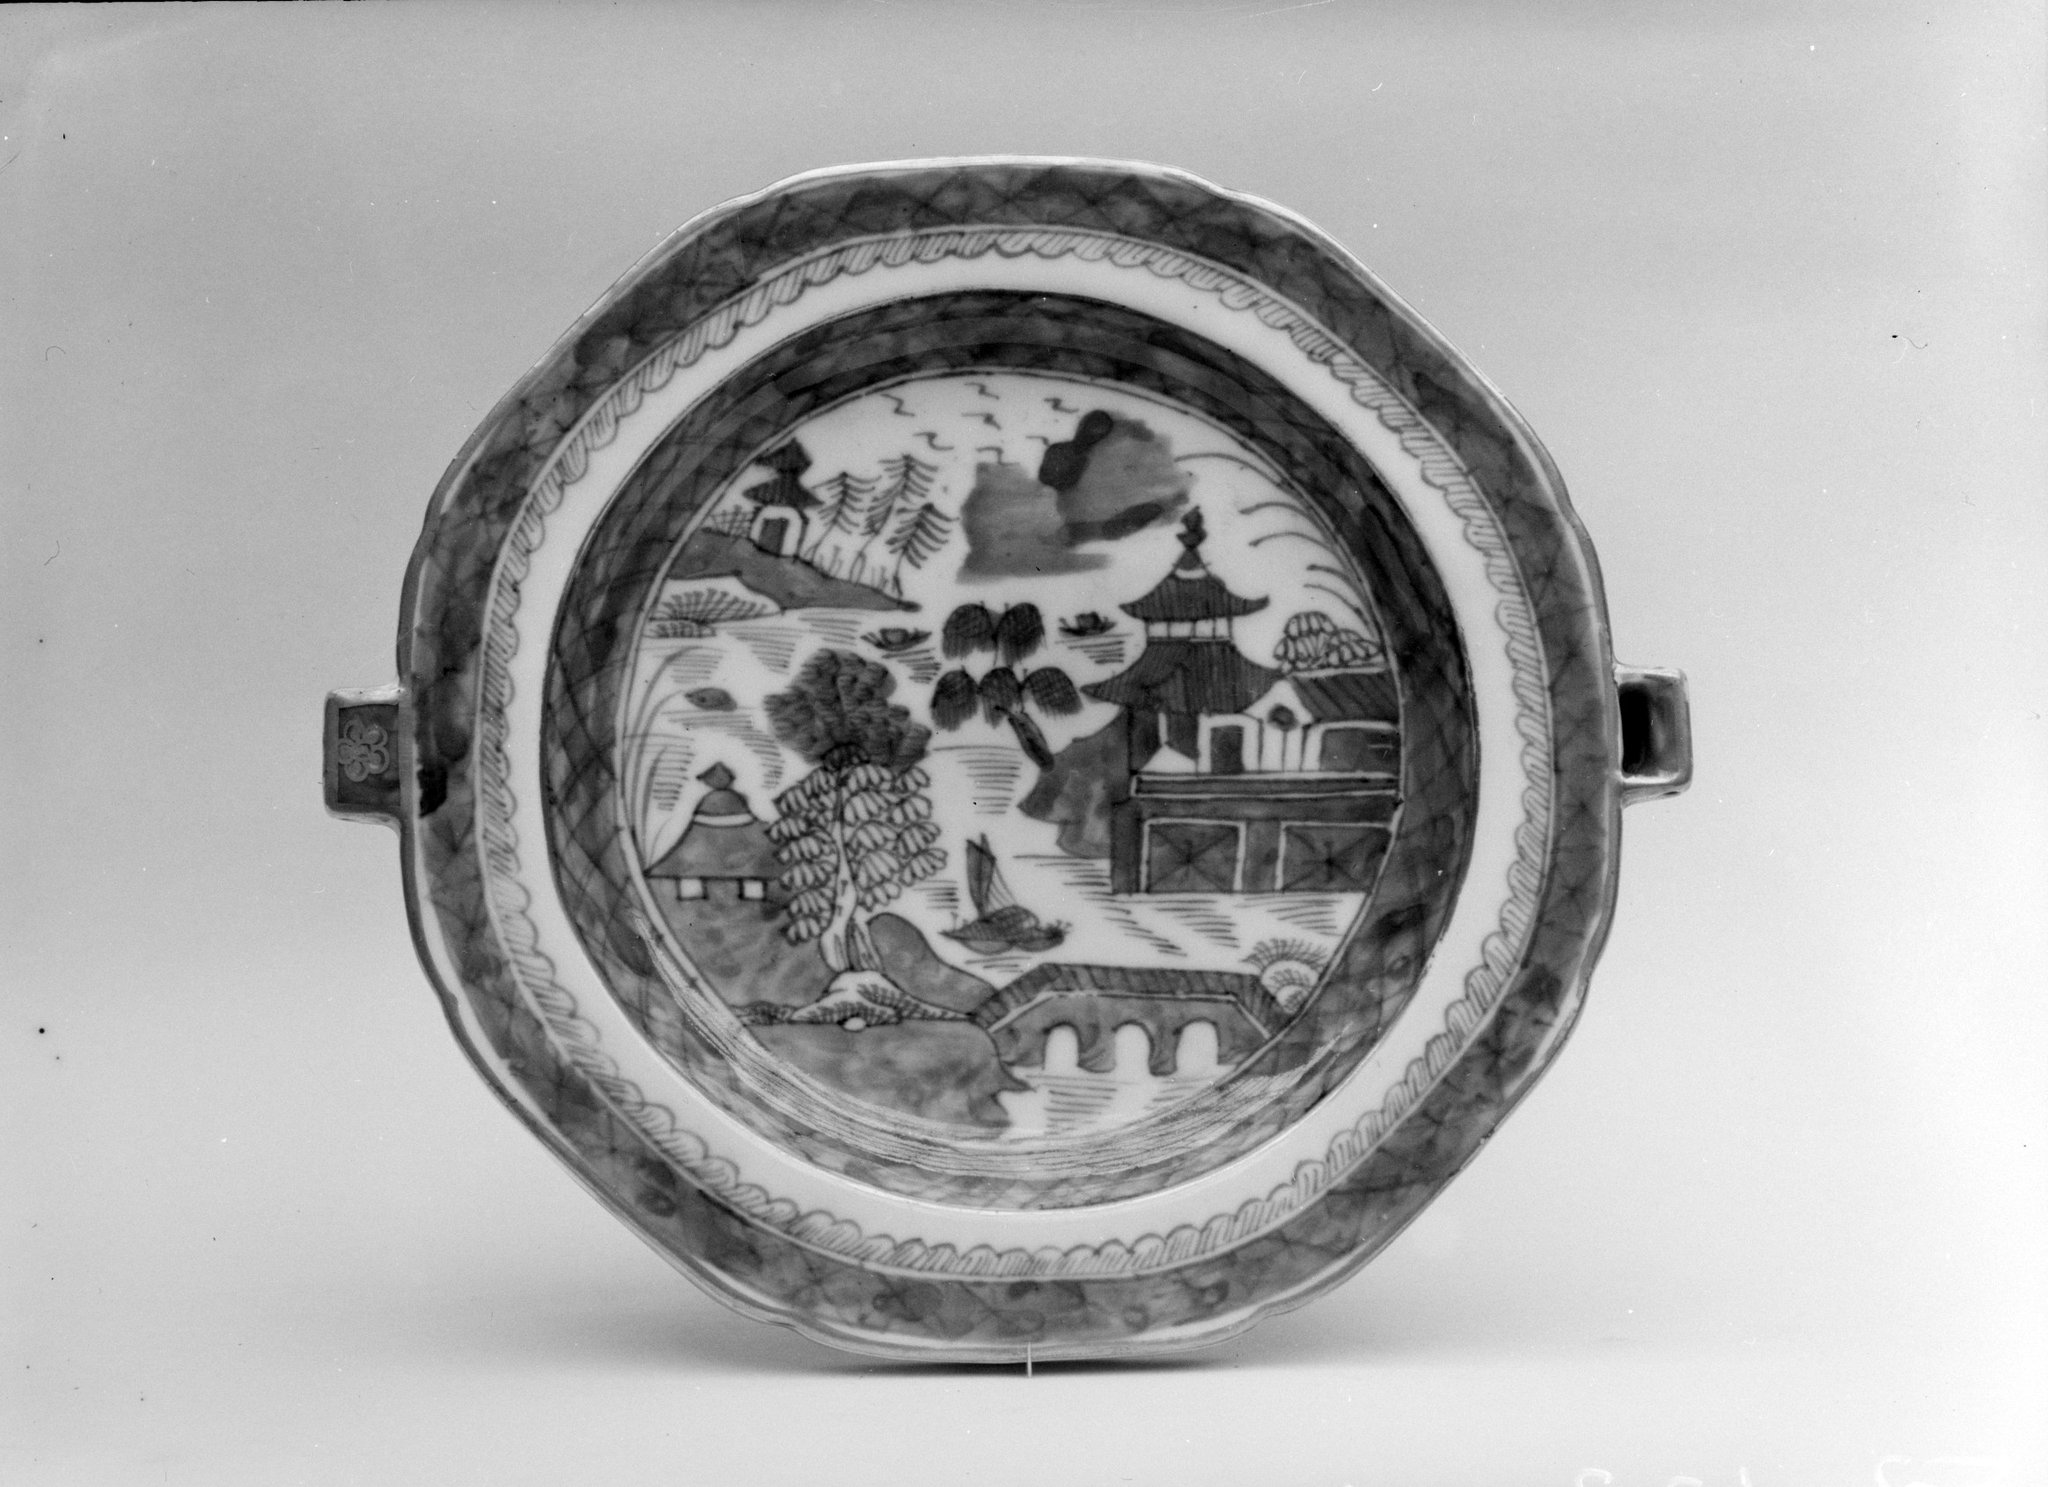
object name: hot water plate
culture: chinese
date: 1800-1830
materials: porcelain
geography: china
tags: bridges,landscapes,boats